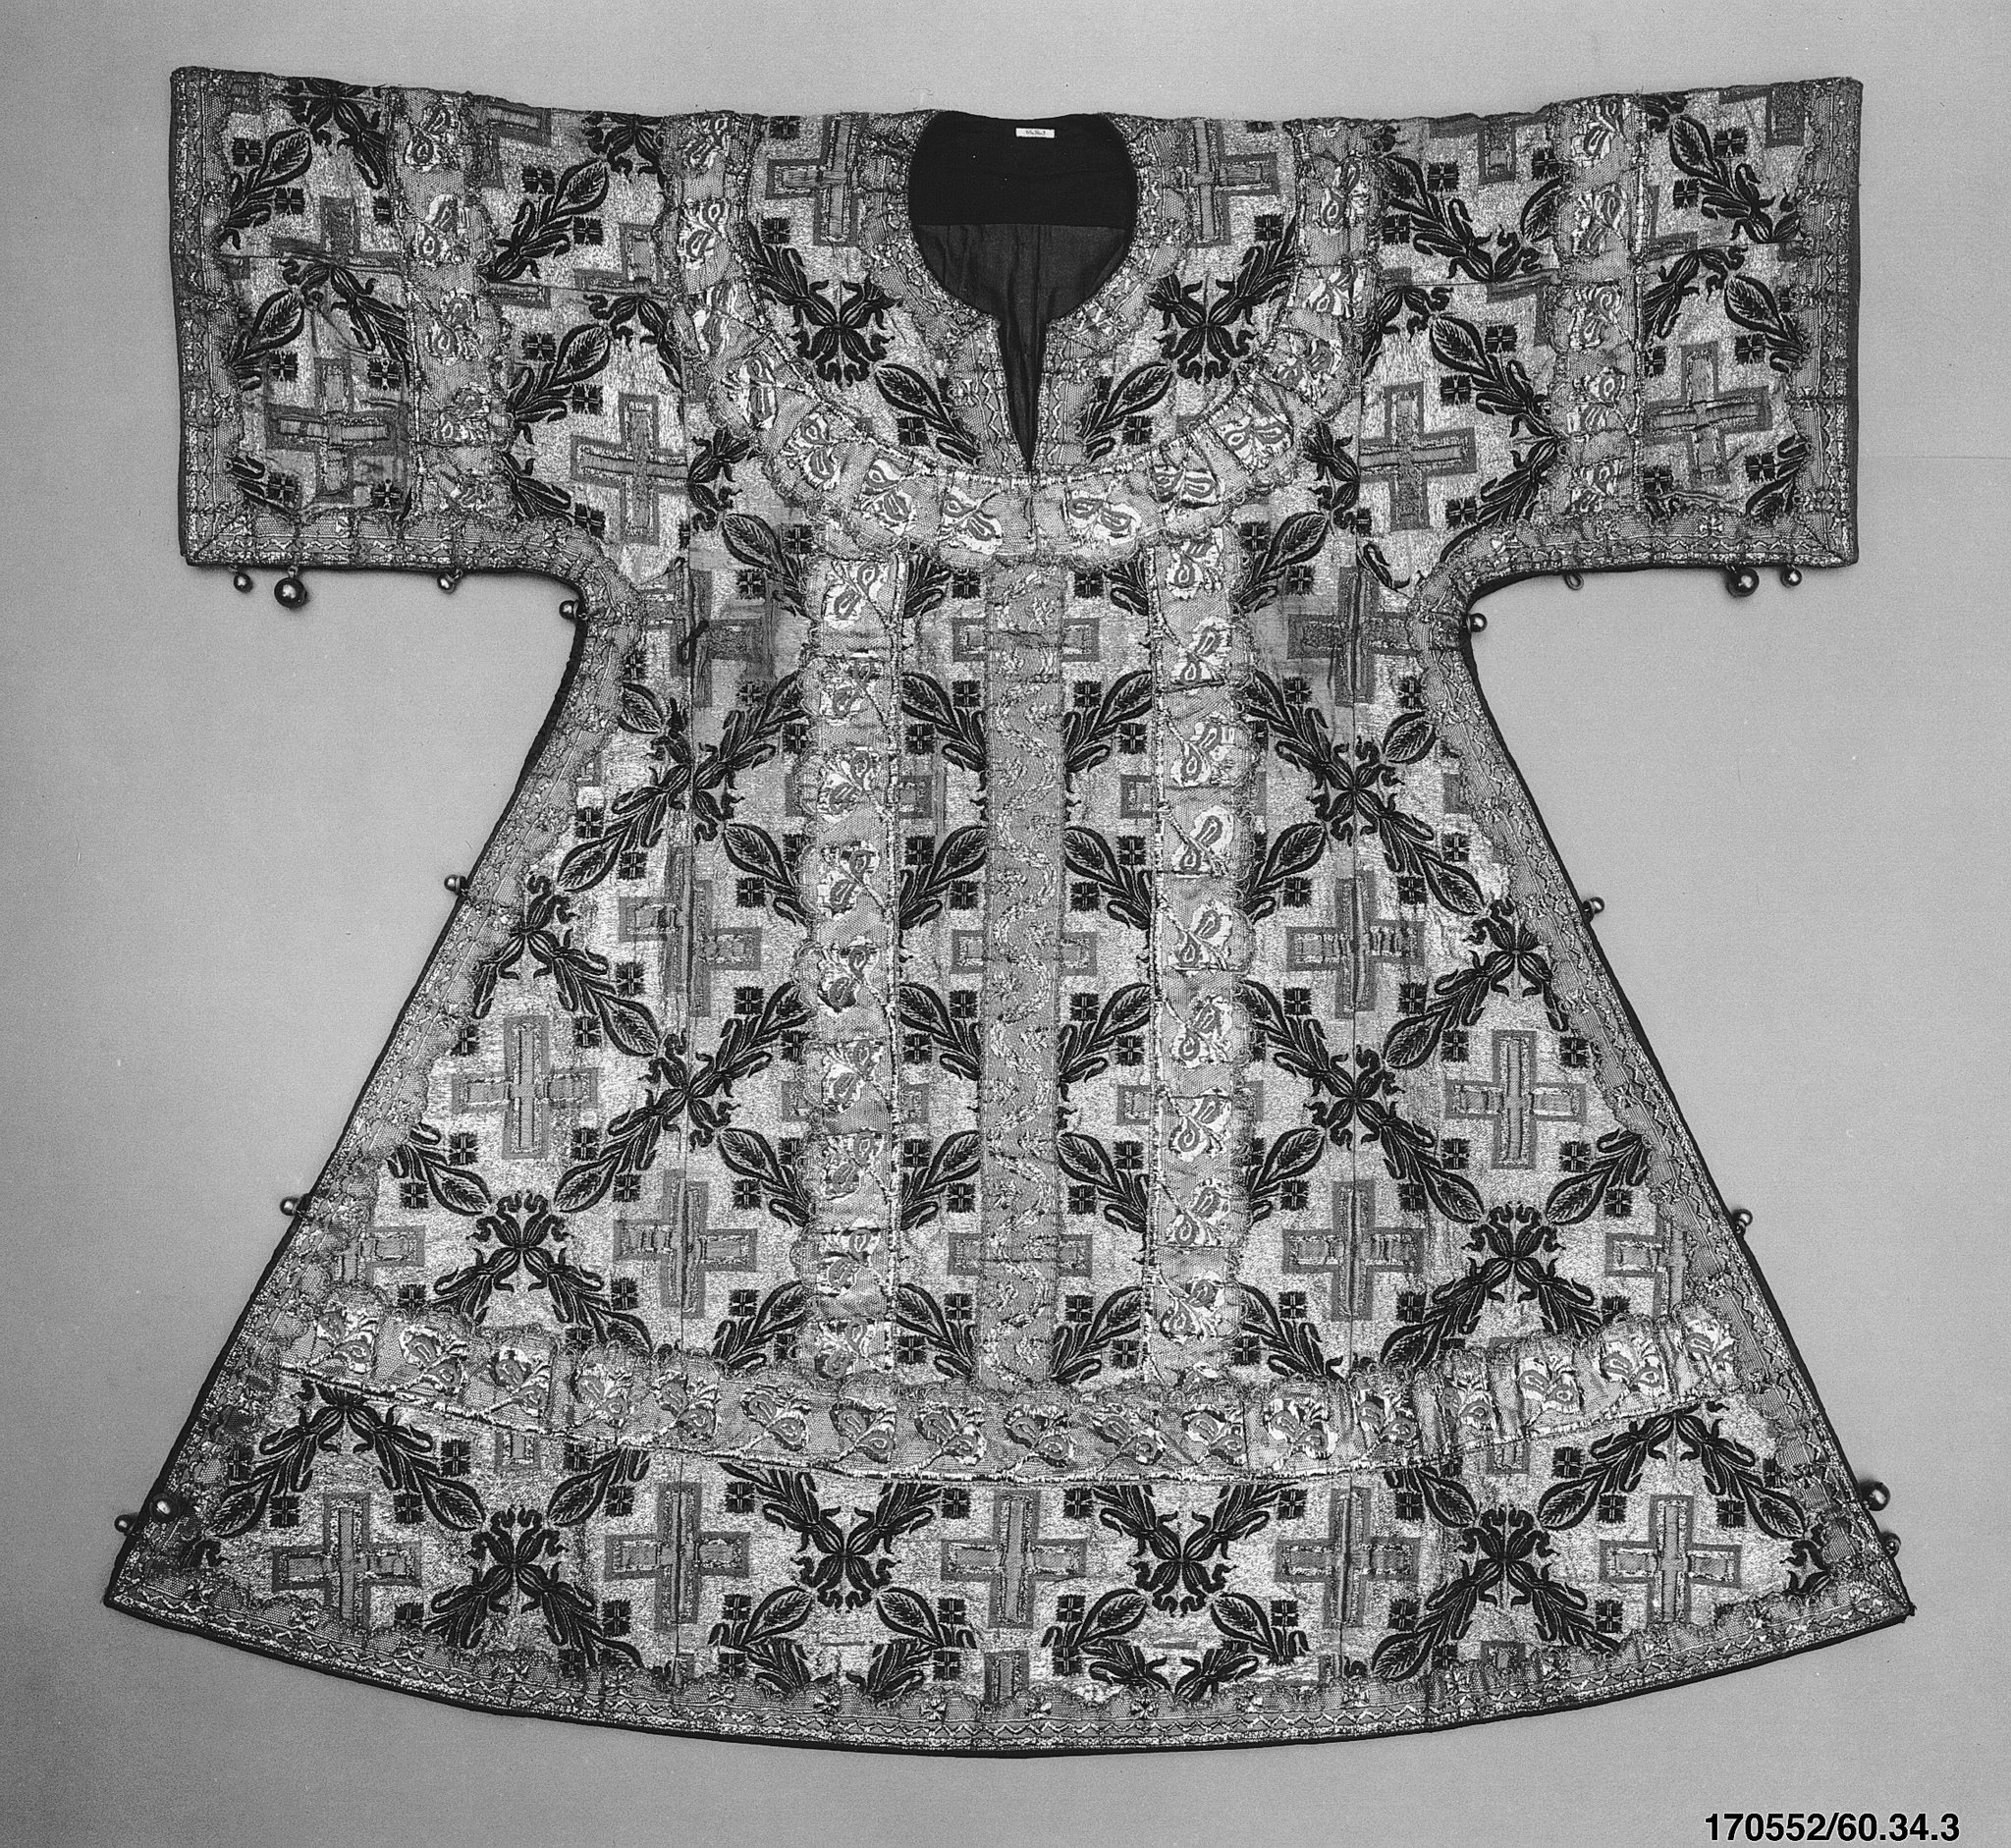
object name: sacco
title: Saccos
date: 1829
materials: metal thread, silk